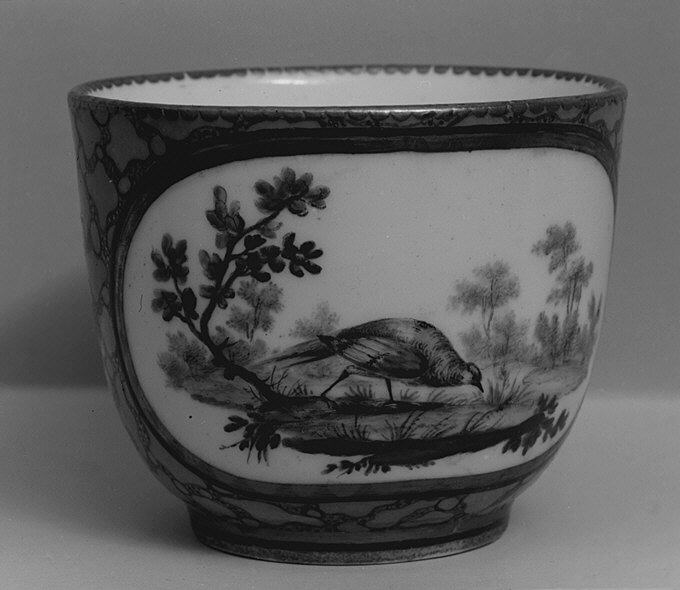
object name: cup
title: Cup with handle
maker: sèvres manufactory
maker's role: manufactory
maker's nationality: french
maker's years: 1740-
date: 1760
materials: soft paste porcelain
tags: birds,trees